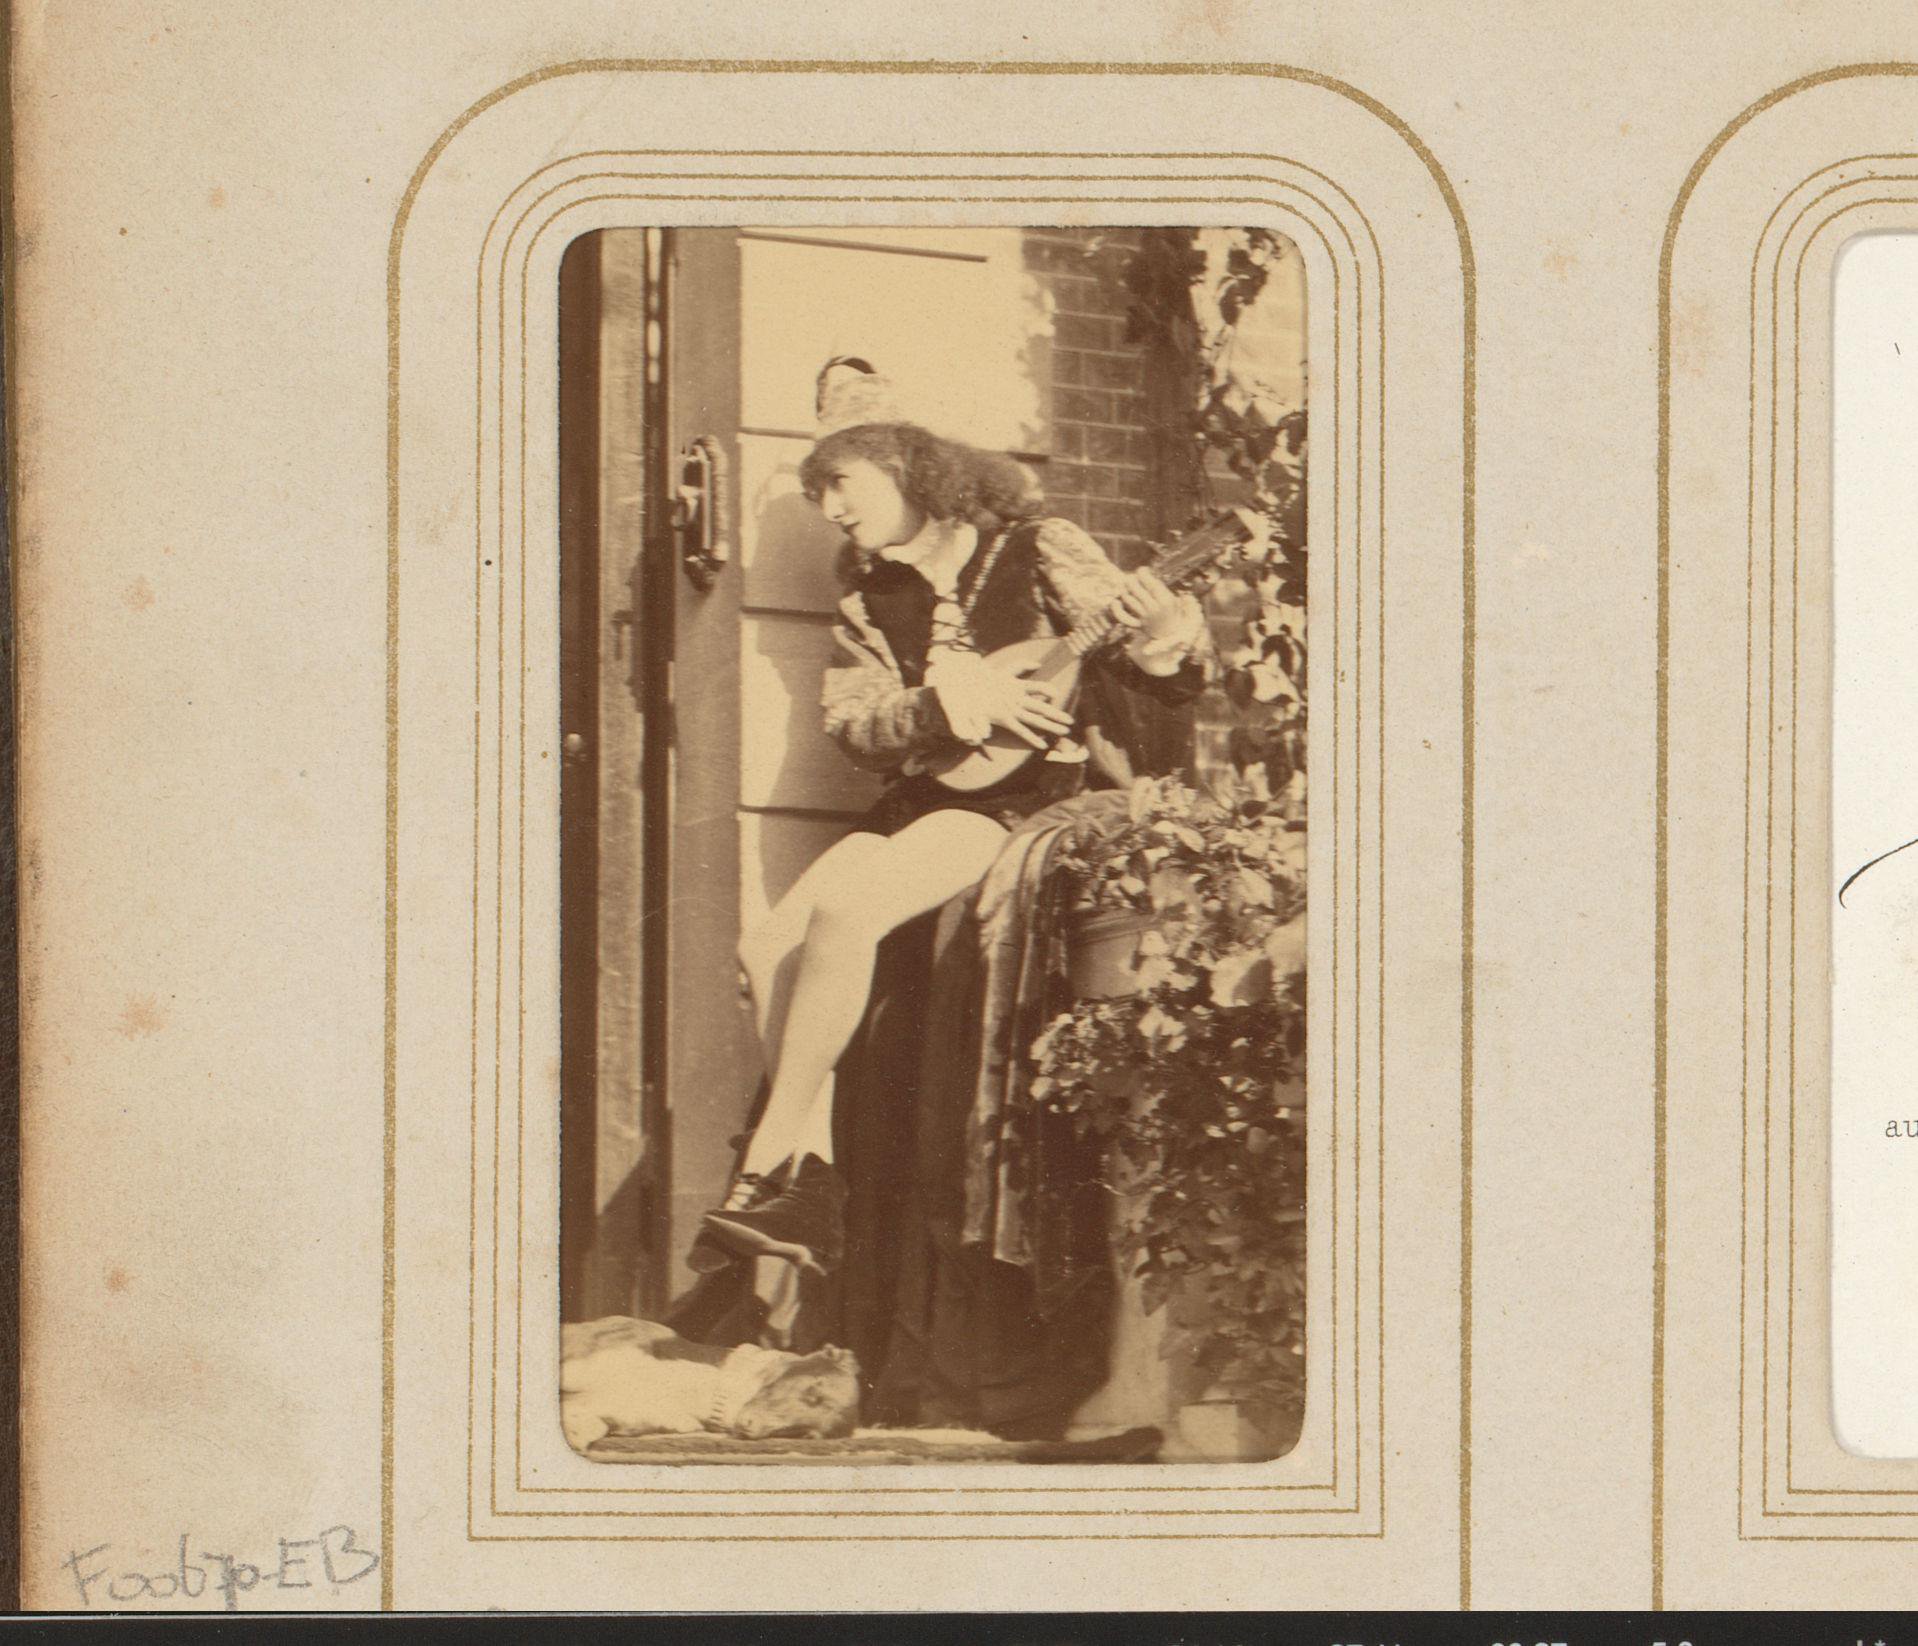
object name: carte de visite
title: Portret van Sarah Bernhardt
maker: achille mélandri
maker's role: publisher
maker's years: 1845-1905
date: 1870-1880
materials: cardboard, photographic support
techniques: albumen print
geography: paris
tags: paris, sculptor, sarah bernhardt, historical persons - bb - woman, portrait of actor, actress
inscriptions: annotation: ‘A. Melandri/ 85,-’, inscription: ‘Melandri/ 19, Rue Clauzel’, annotation: ‘Sarah Bernhardt 1844-1923/ (= Rosine Bernhard) fr. actrice / (foto Melandri)’